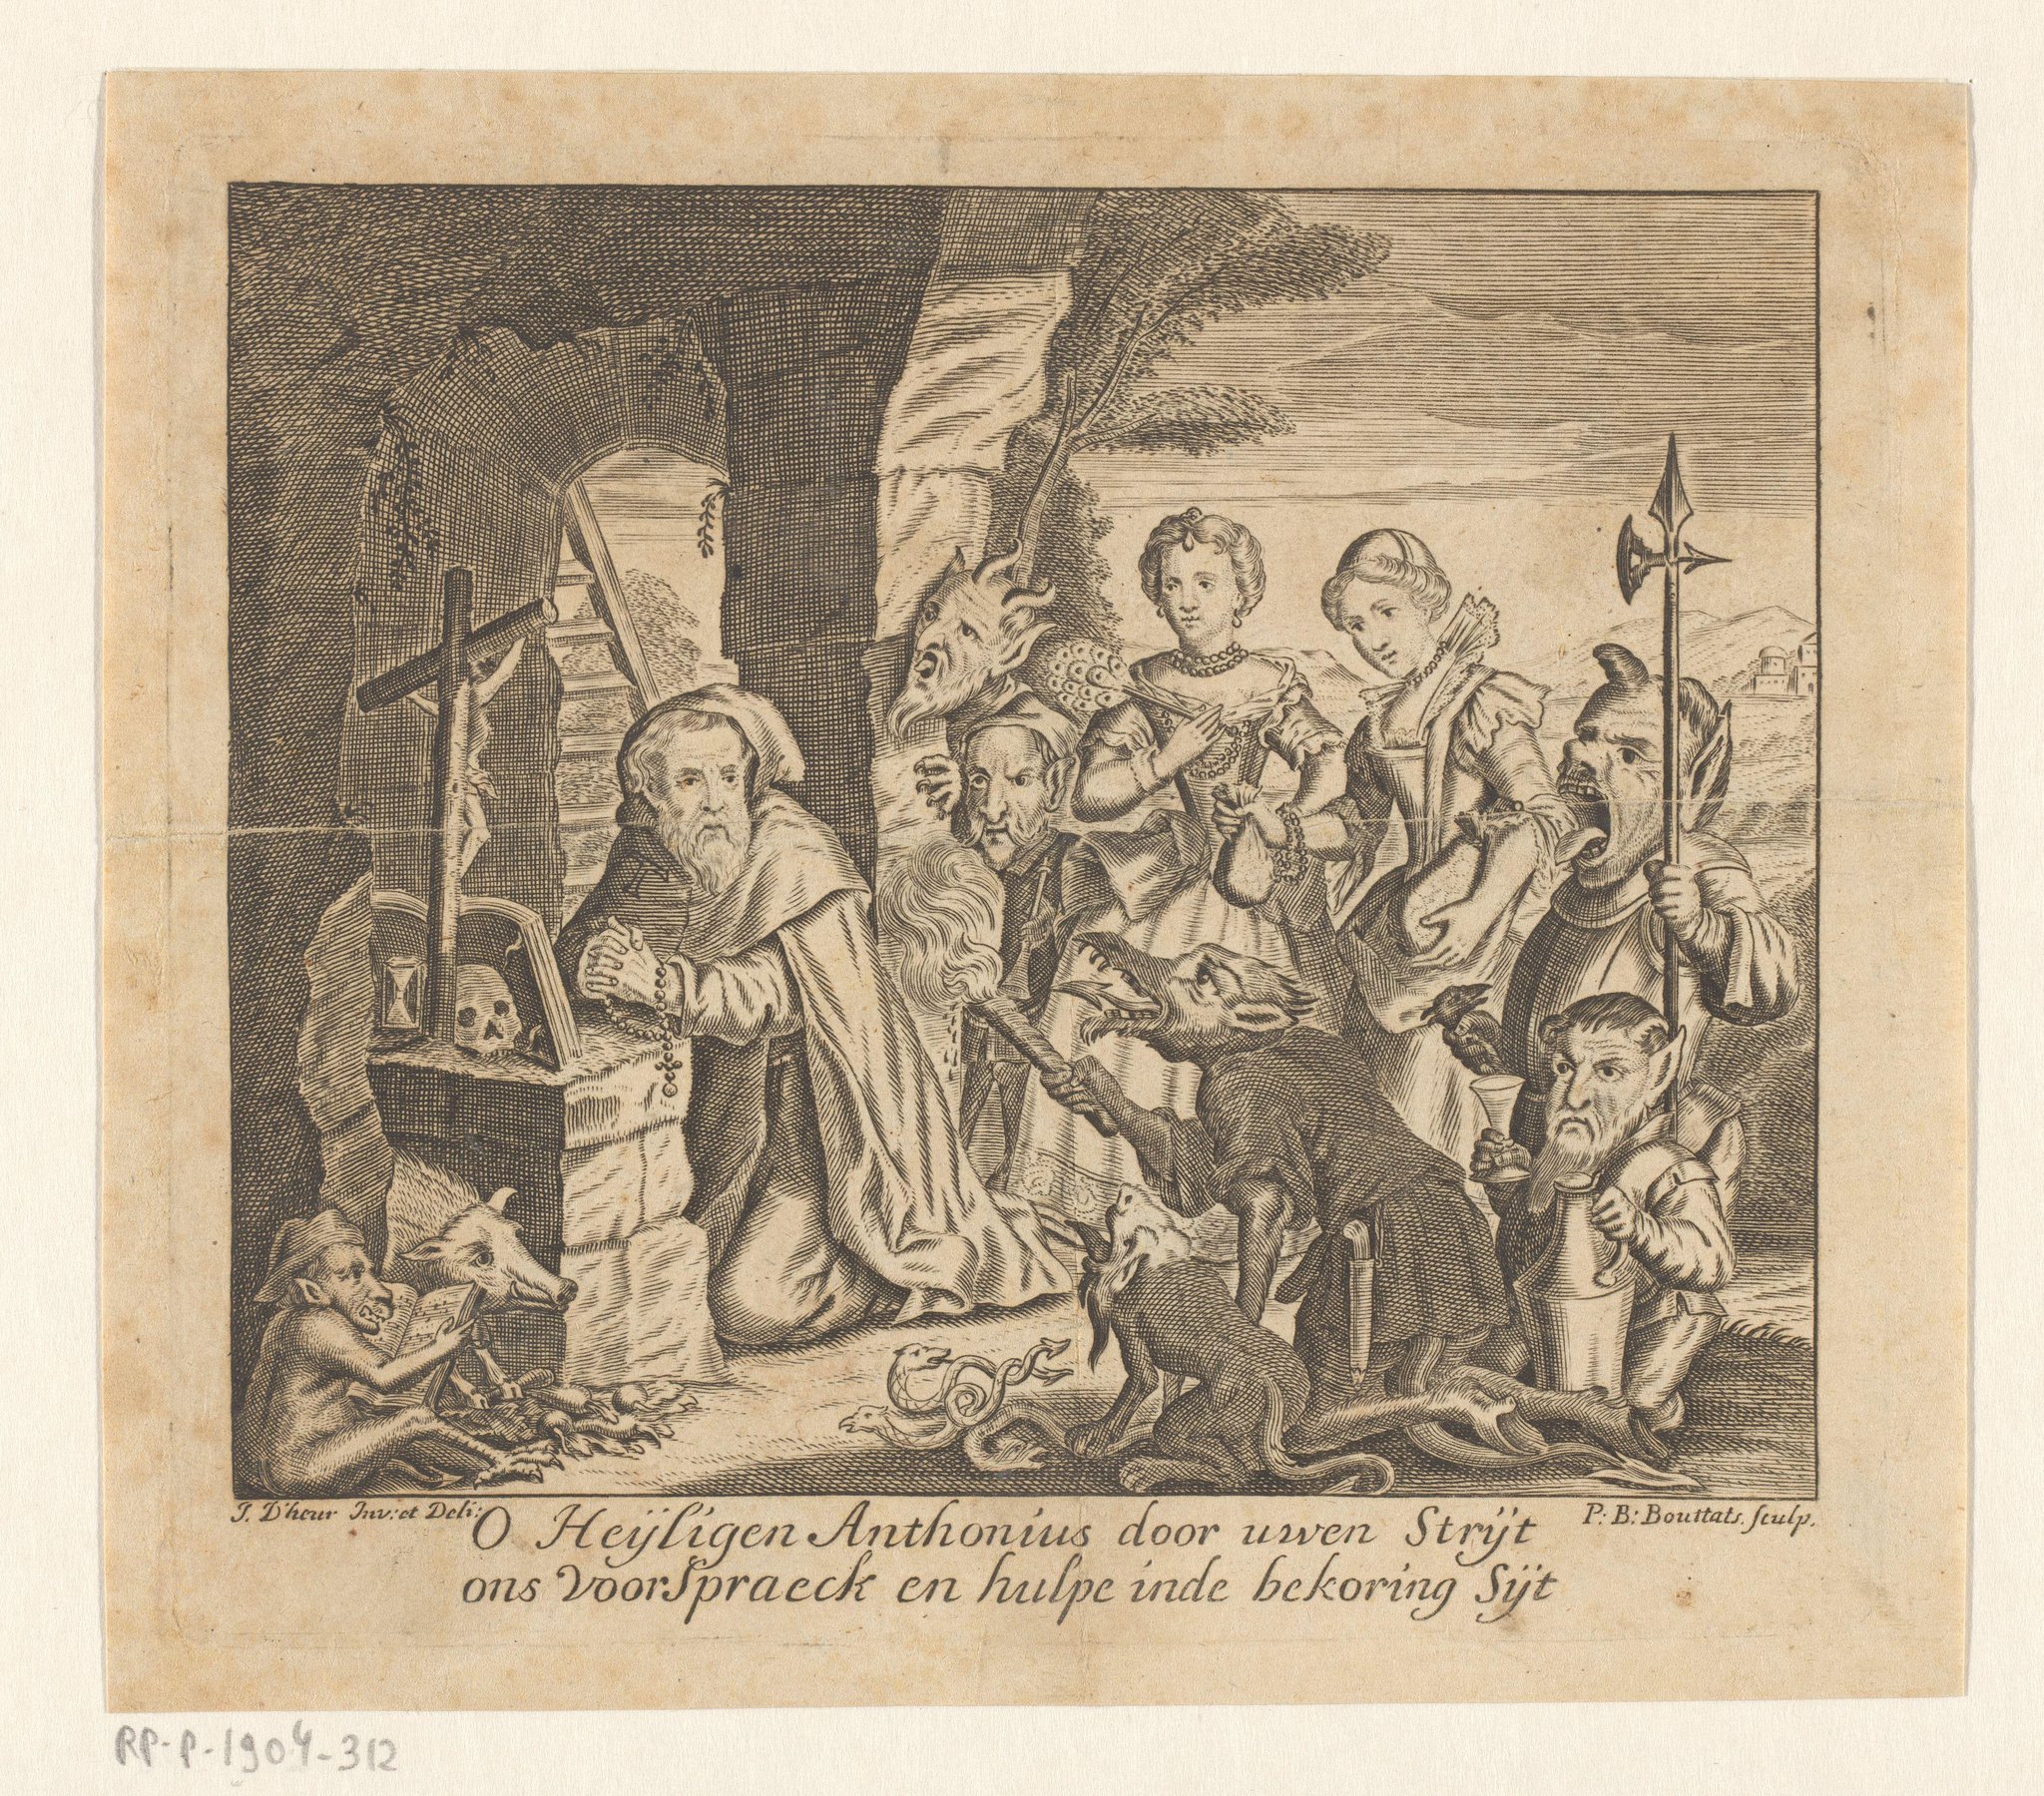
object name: print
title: Verzoeking van de Heilige Antonius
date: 1676-1755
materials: paper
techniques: engraving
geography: antwerp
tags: temptations of st. antony abbot, the erotic visions of st. antony abbot: he is tempted by (naked) women, but drives them off by praying, or by showing them a crucifix, the hermit antony abbot (antonius abbas) of egypt, also called the great; possible attributes: bell, book, t-shaped staff, flames, pig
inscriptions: collector's mark: Lugt 2228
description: De Heilige Antonius knielt voor een kruisbeeld in een grot en bidt Christus hem te verlossen van de duivels en demonen die hem verzoeken het slechte pad te bewandelen. Rondom Antonius verzamelen zich allerlei Boschiaanse duiveltjes, alsook twee dames die ijdelheid, lust en hebzucht vertegenwoordigen. Onder de prent een Nederlands onderschrift: 'O Heylighen Anthonius door uwen strijt ons voorspraeck en hulpe inde bekoring Sijt'.